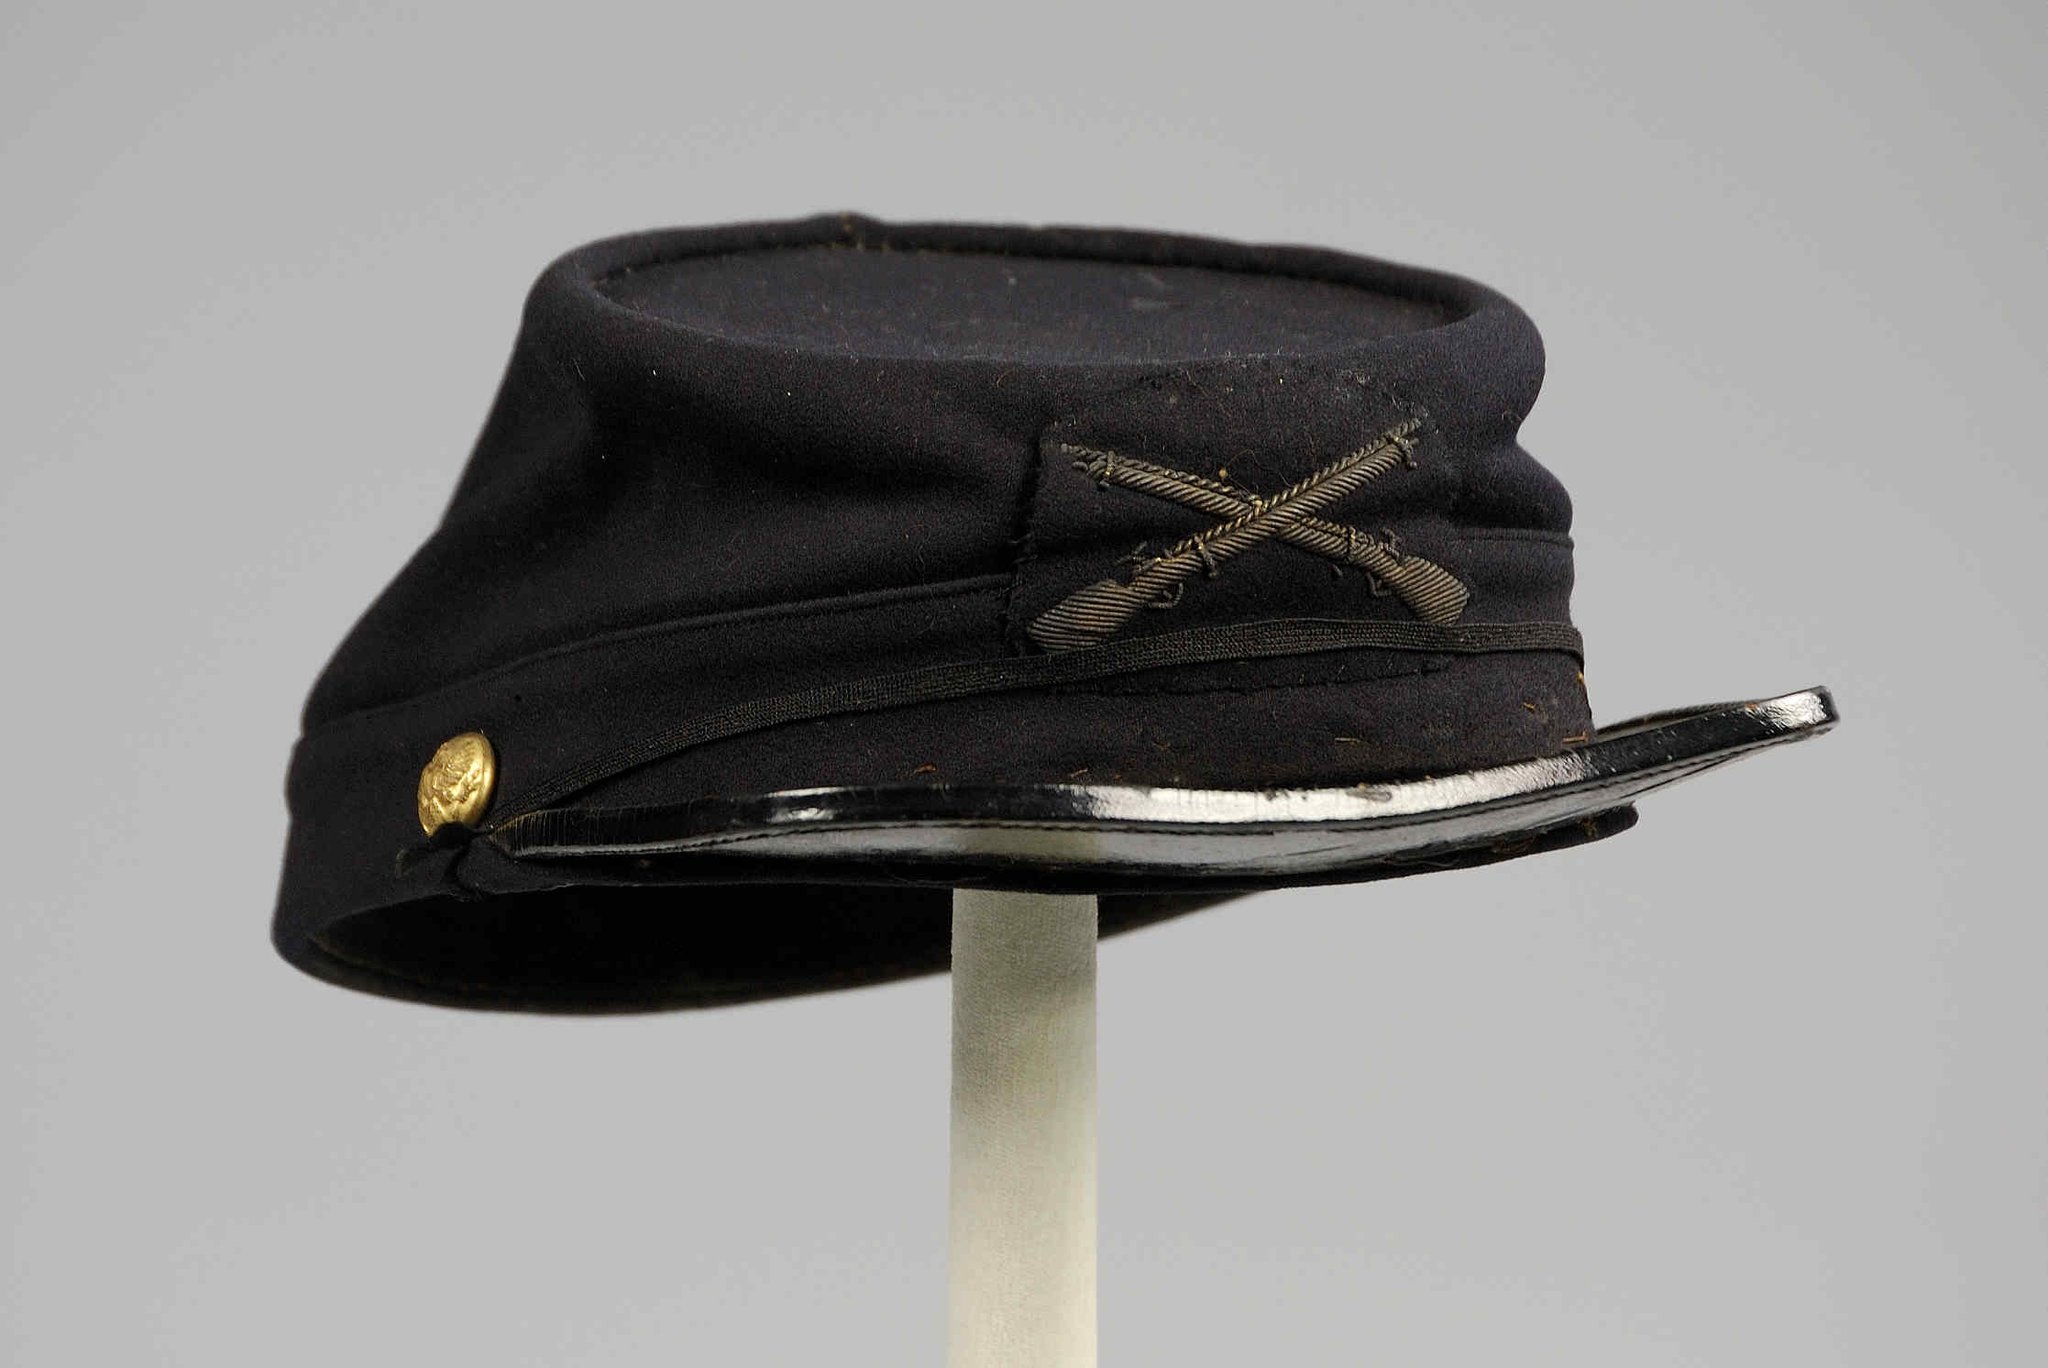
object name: military cap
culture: american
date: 1881-1882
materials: leather, metal, wool